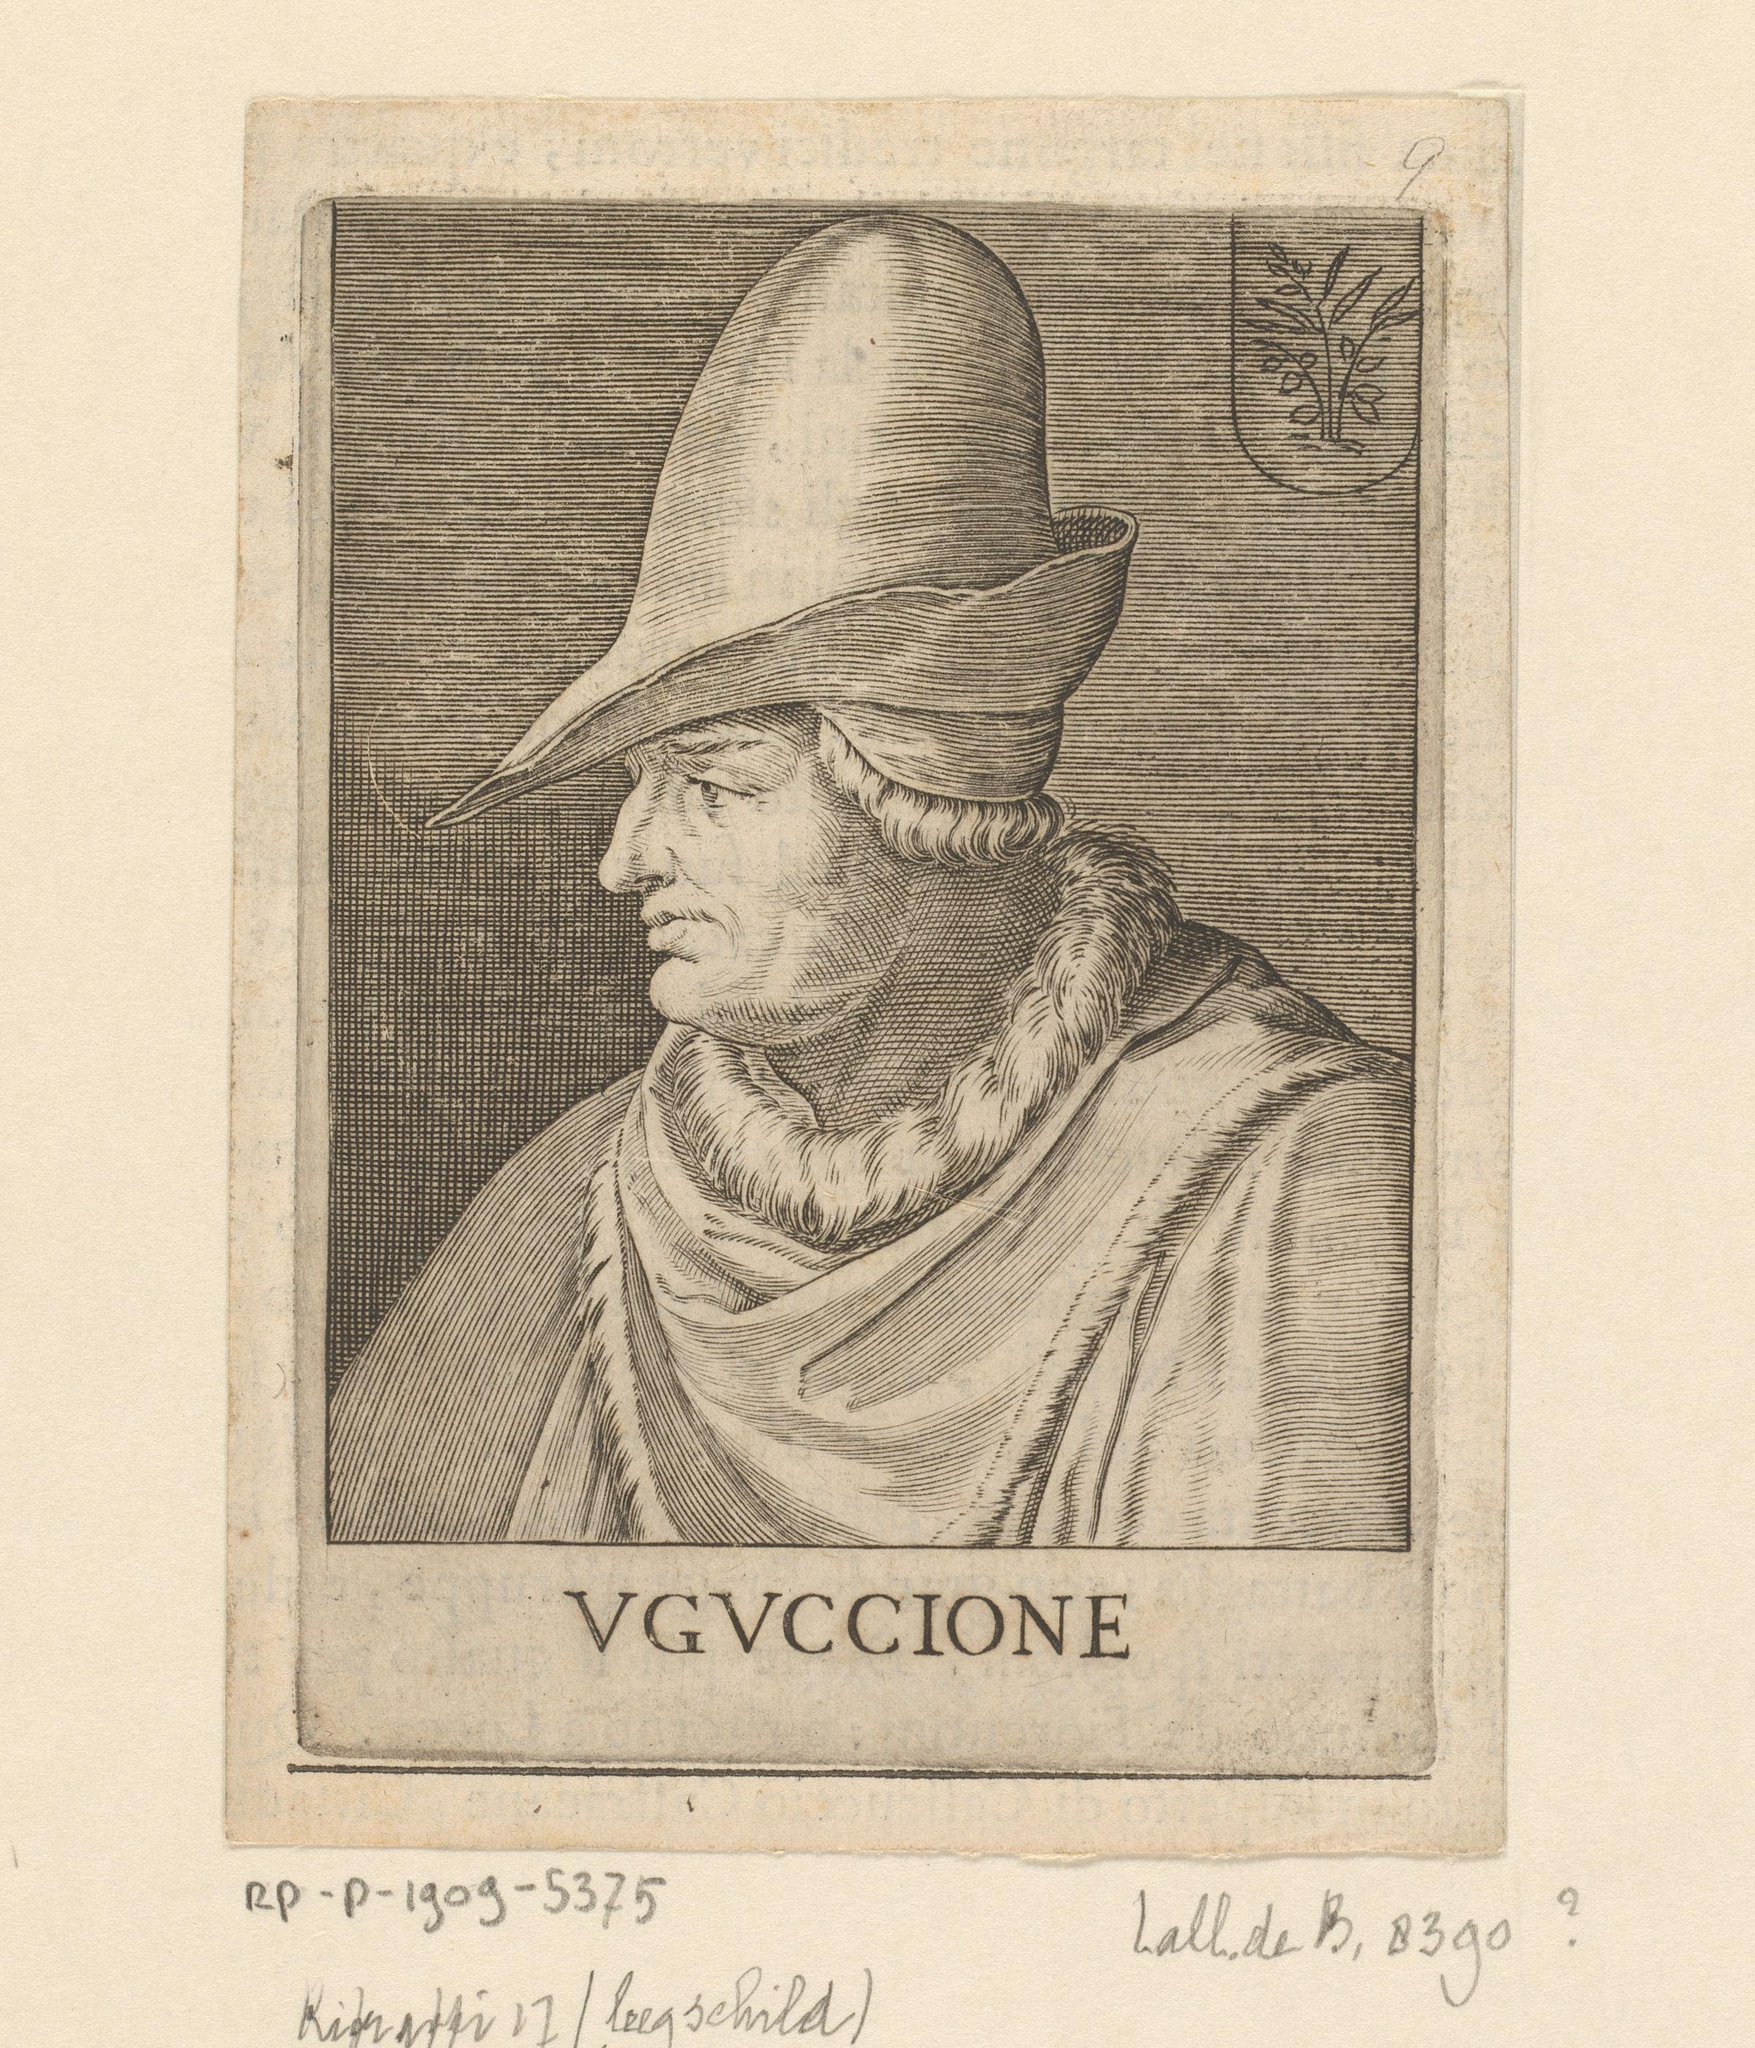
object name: book illustration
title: Portret van legeraanvoerder Uguccione della Faggiola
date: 1546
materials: paper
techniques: engraving, letterpress printing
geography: rome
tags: commander-in-chief, general, marshal, historical persons, armorial bearing, heraldry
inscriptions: collector's mark: Lugt 2228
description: Prent uit: Ritratti et elogii di capitani Illustri. Che ne'secoli moderni hanno gloriosamente guerreggiato. Rome: Filippo de'Rossi en Vitale Mascardi, 1646, p. 27. Eerdere staten van prent ook gebruikt in: Ritratti et elogii di capitani Illustri. Rome: Pompilio Totti en Andrea Fei, 1635. En in: Ritratti di cento capitani illustri con li lor Fatti in guerra […], Rome: Domenico Gigliotti, 1596.